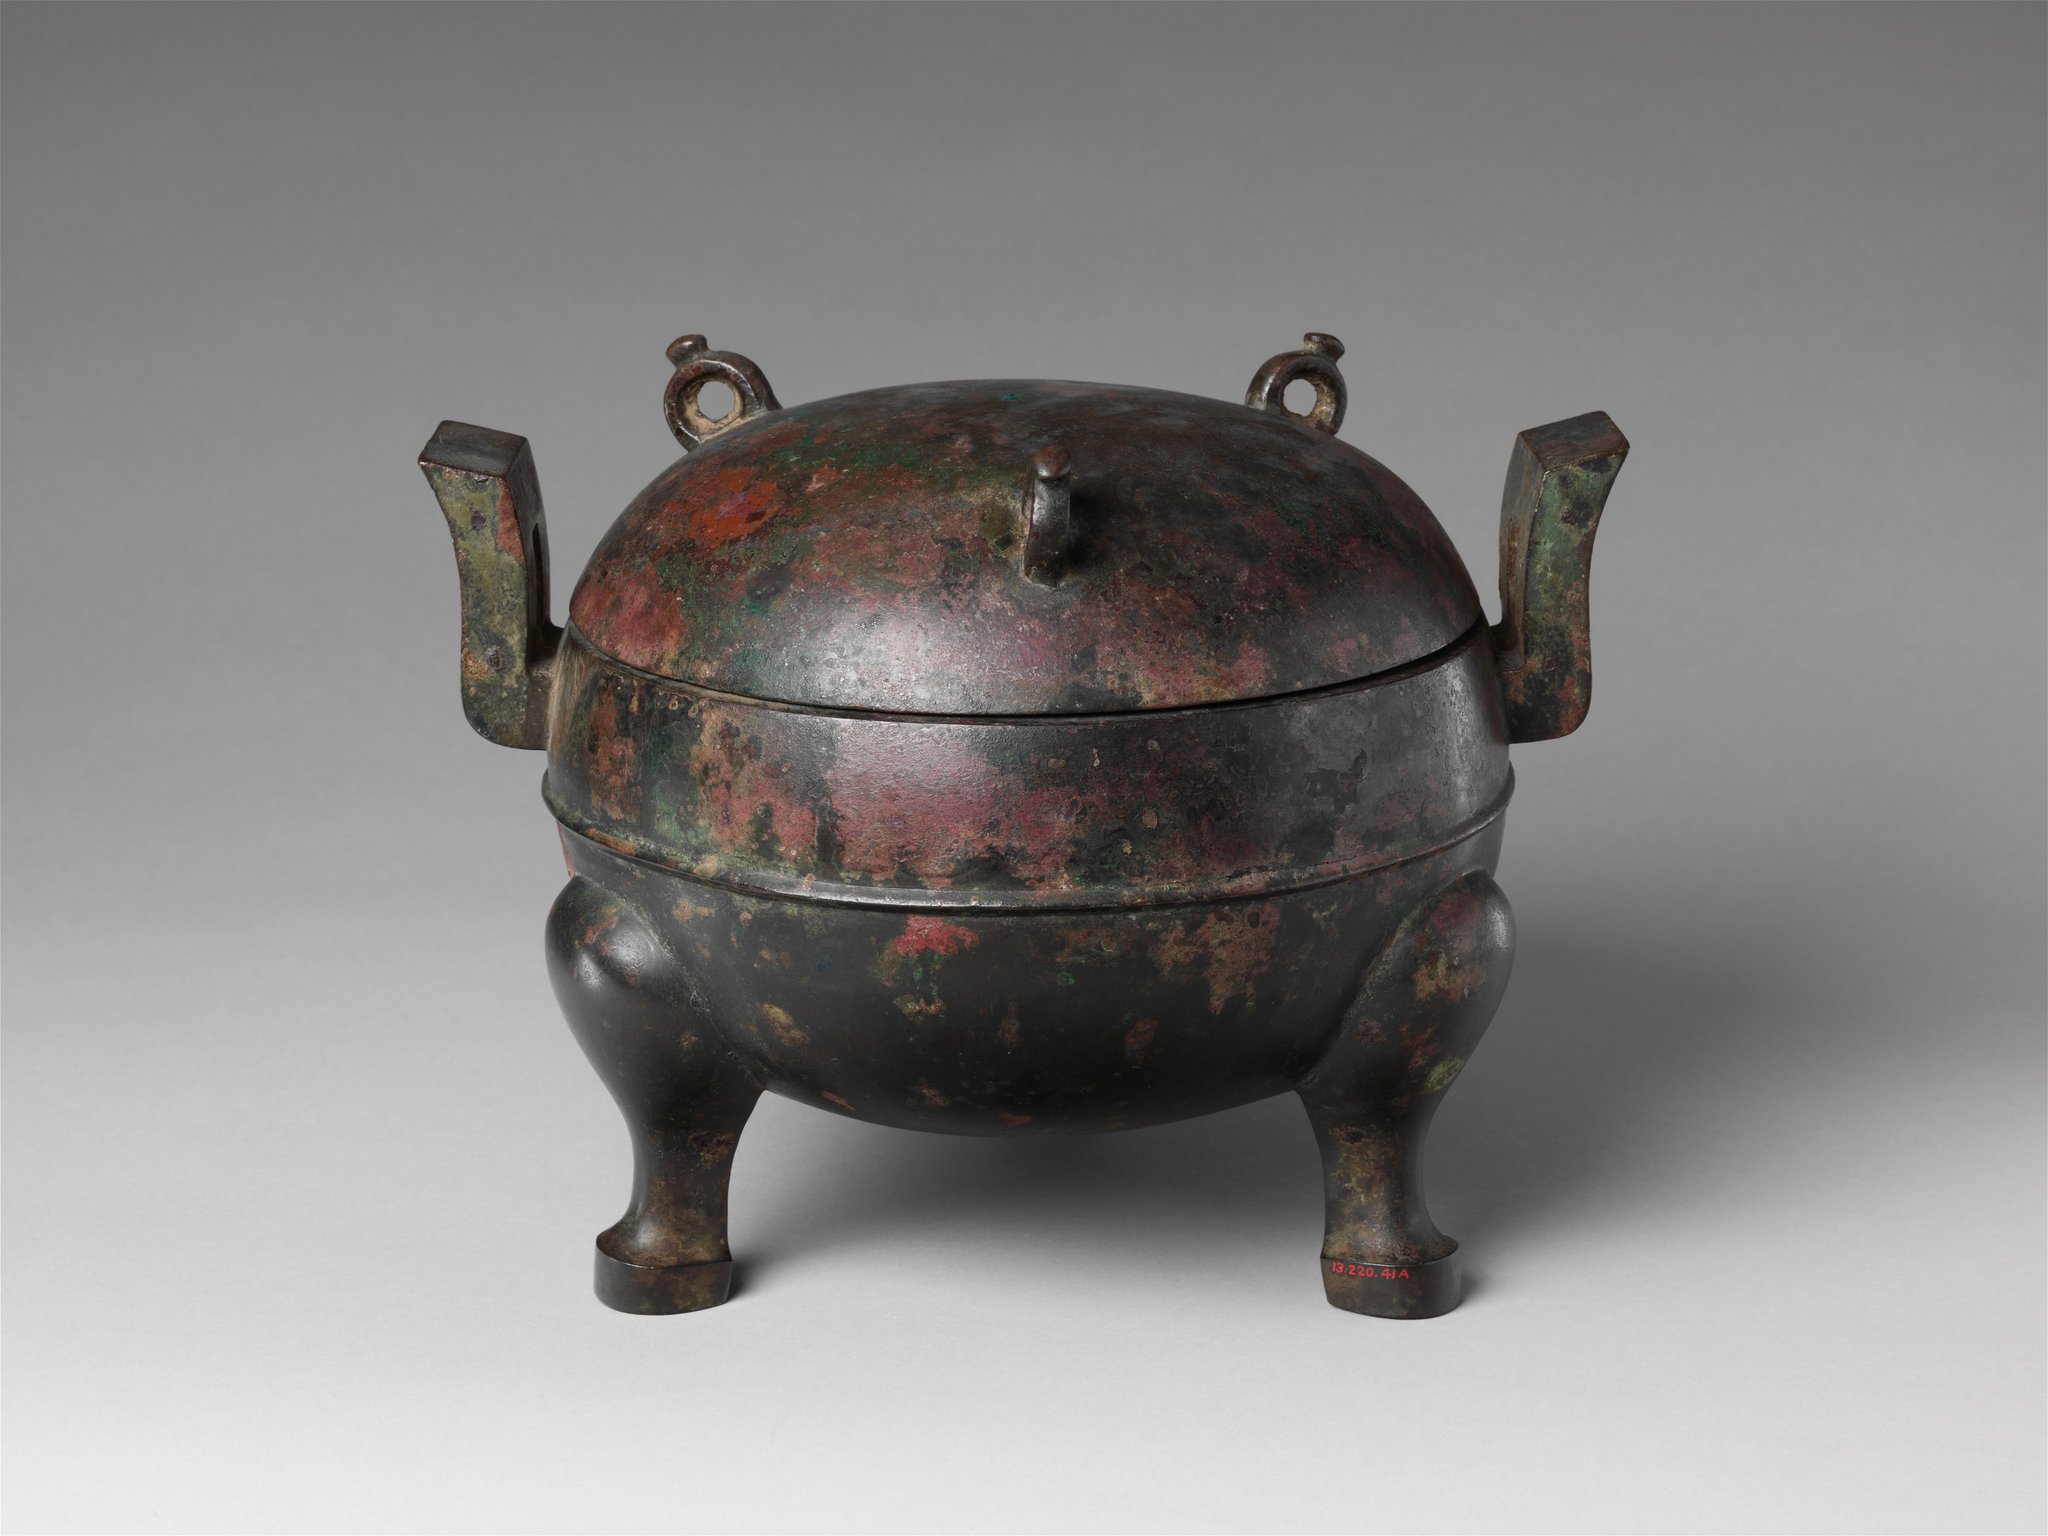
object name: tripod cauldron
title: Ritual Tripod Cauldron with Cover (Ding)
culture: chinese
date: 300-101 BCE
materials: bronze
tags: cauldrons